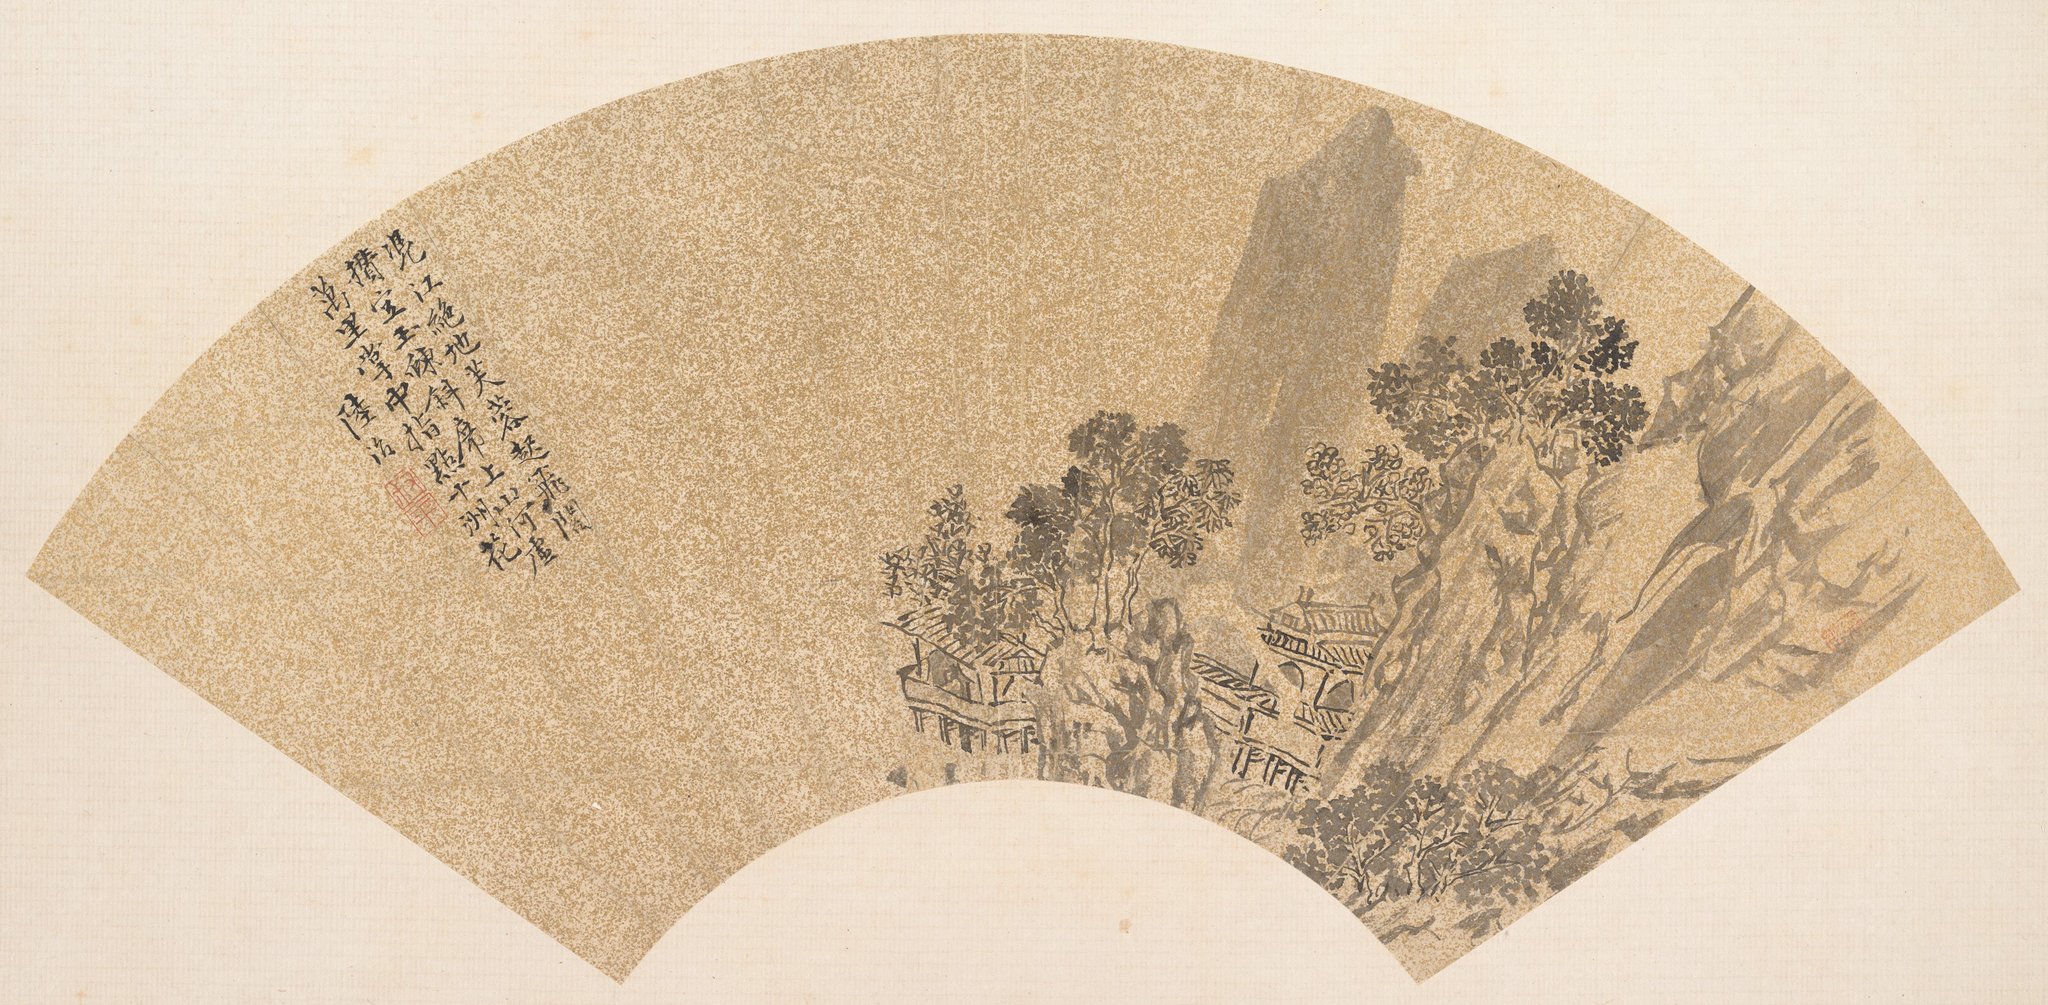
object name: folding fan mounted a an album leaf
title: Landscape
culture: chinese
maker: unidentified artist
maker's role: artist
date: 1501-1600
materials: gold, ink, paper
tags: mountains,landscapes